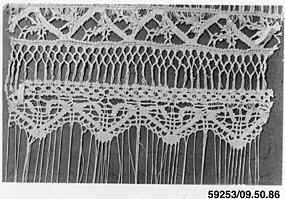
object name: fragment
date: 1601-1633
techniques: lace